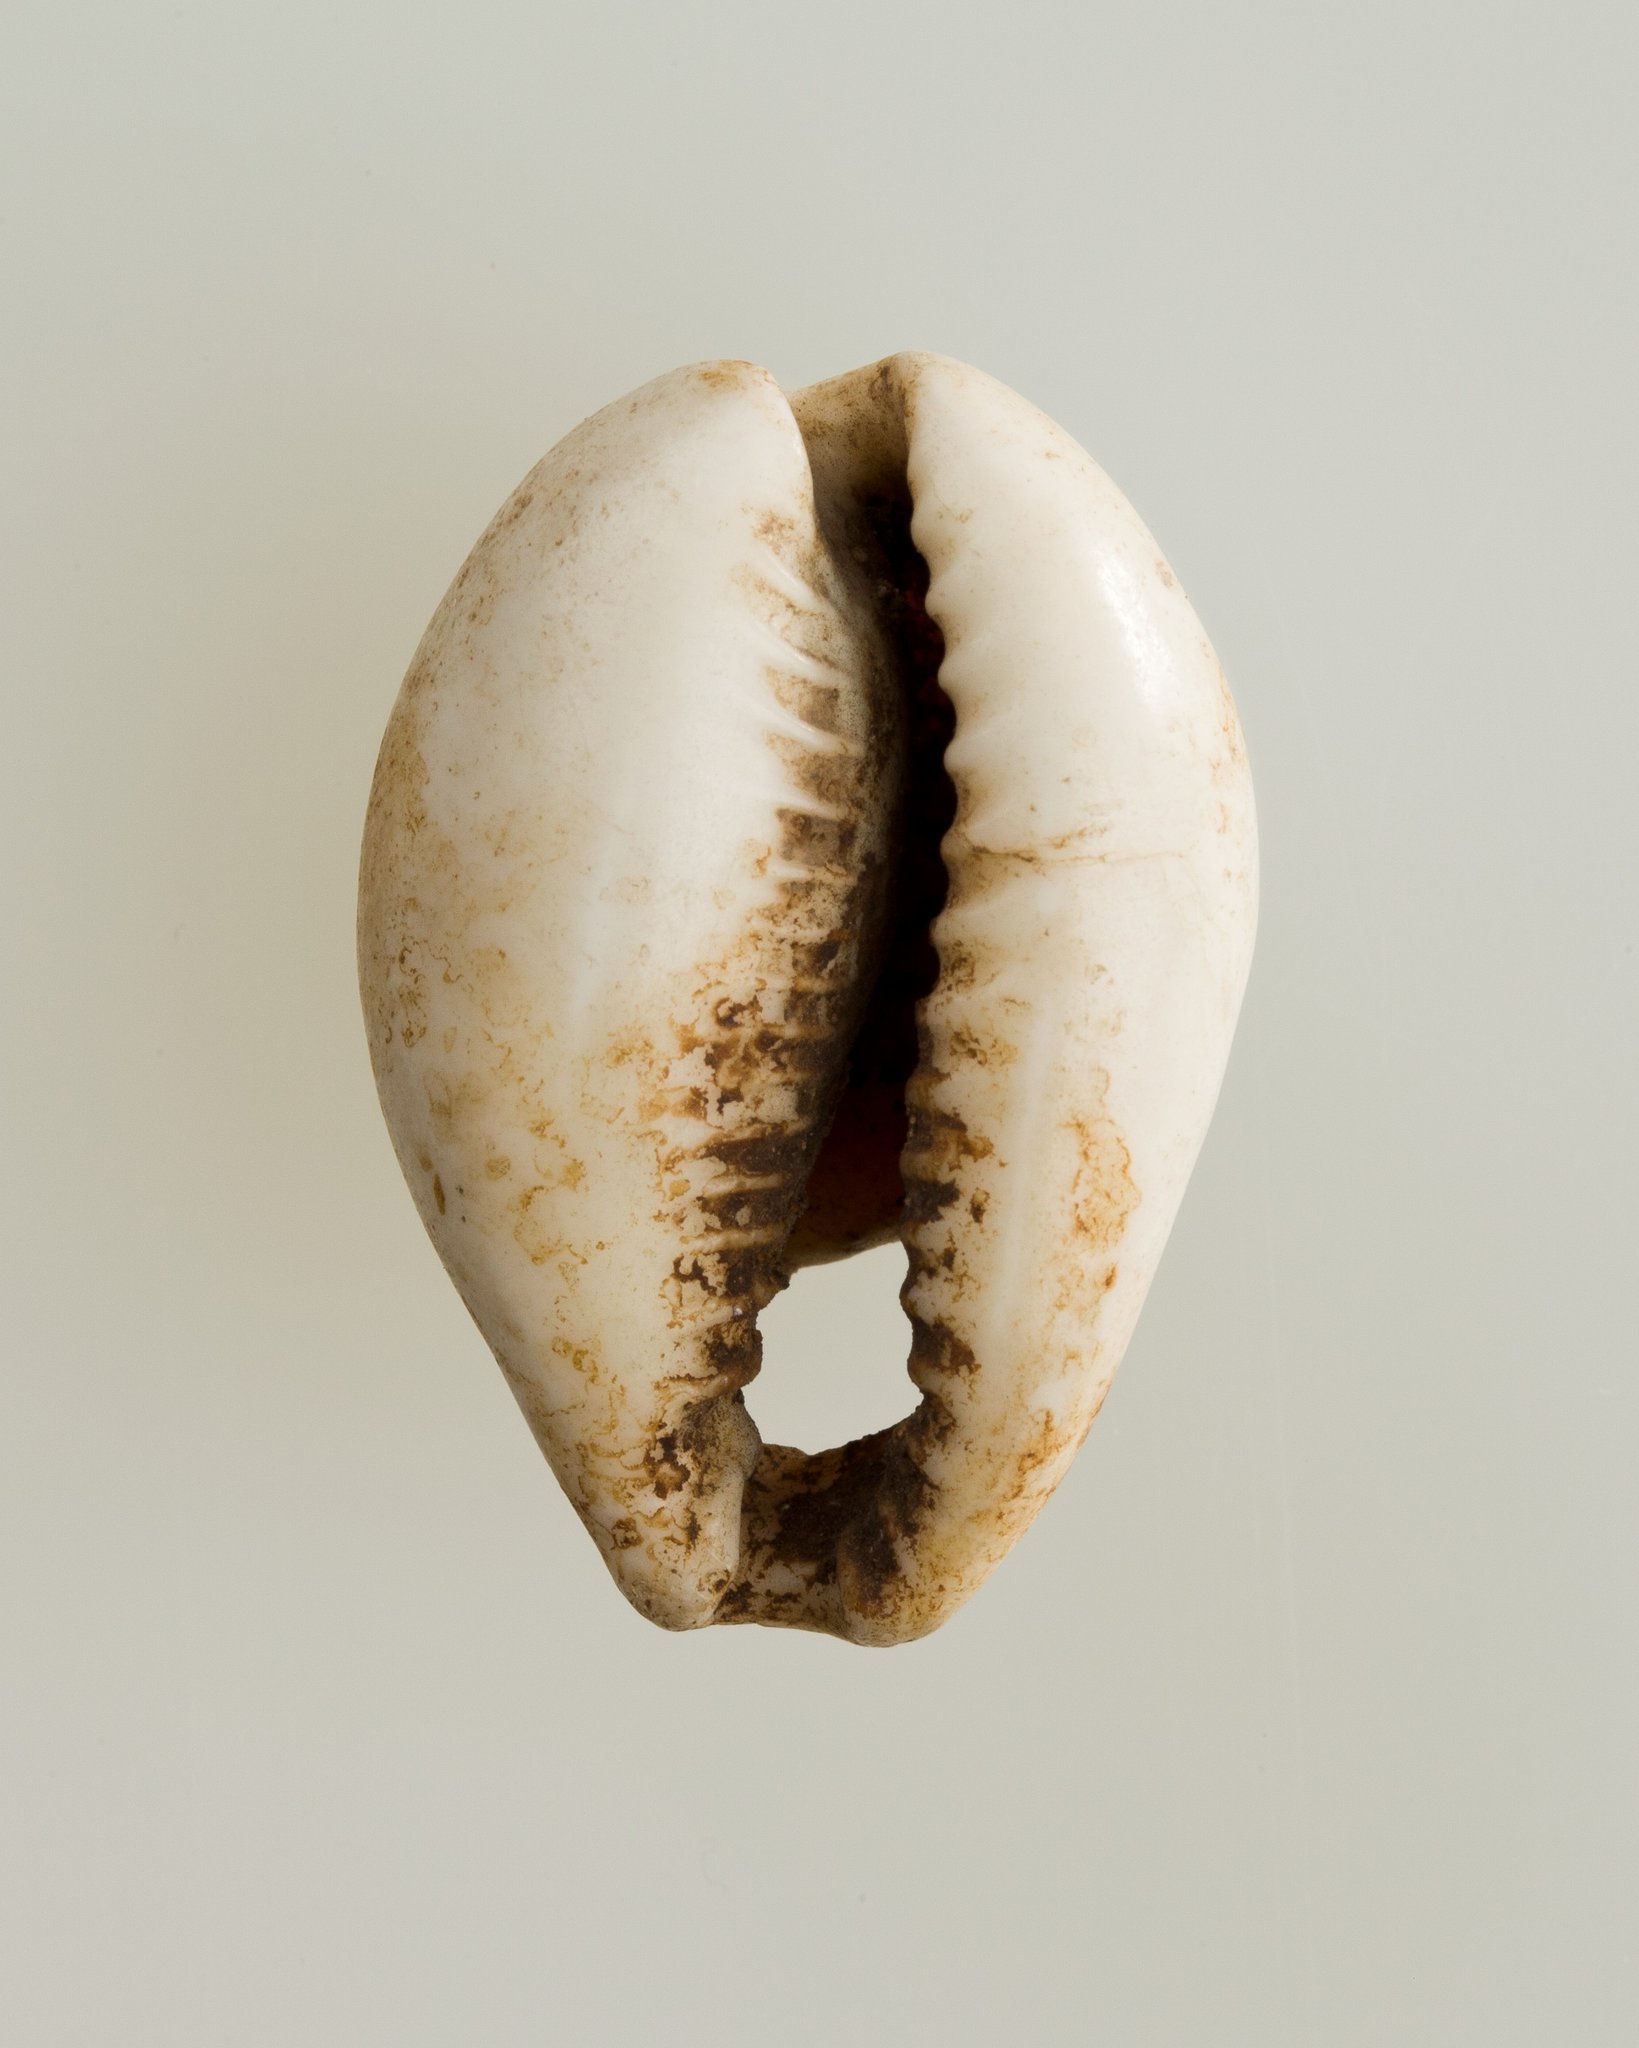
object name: pendant, shell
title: Shell pendant or bead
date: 3850-2960 BCE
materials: shell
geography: egypt